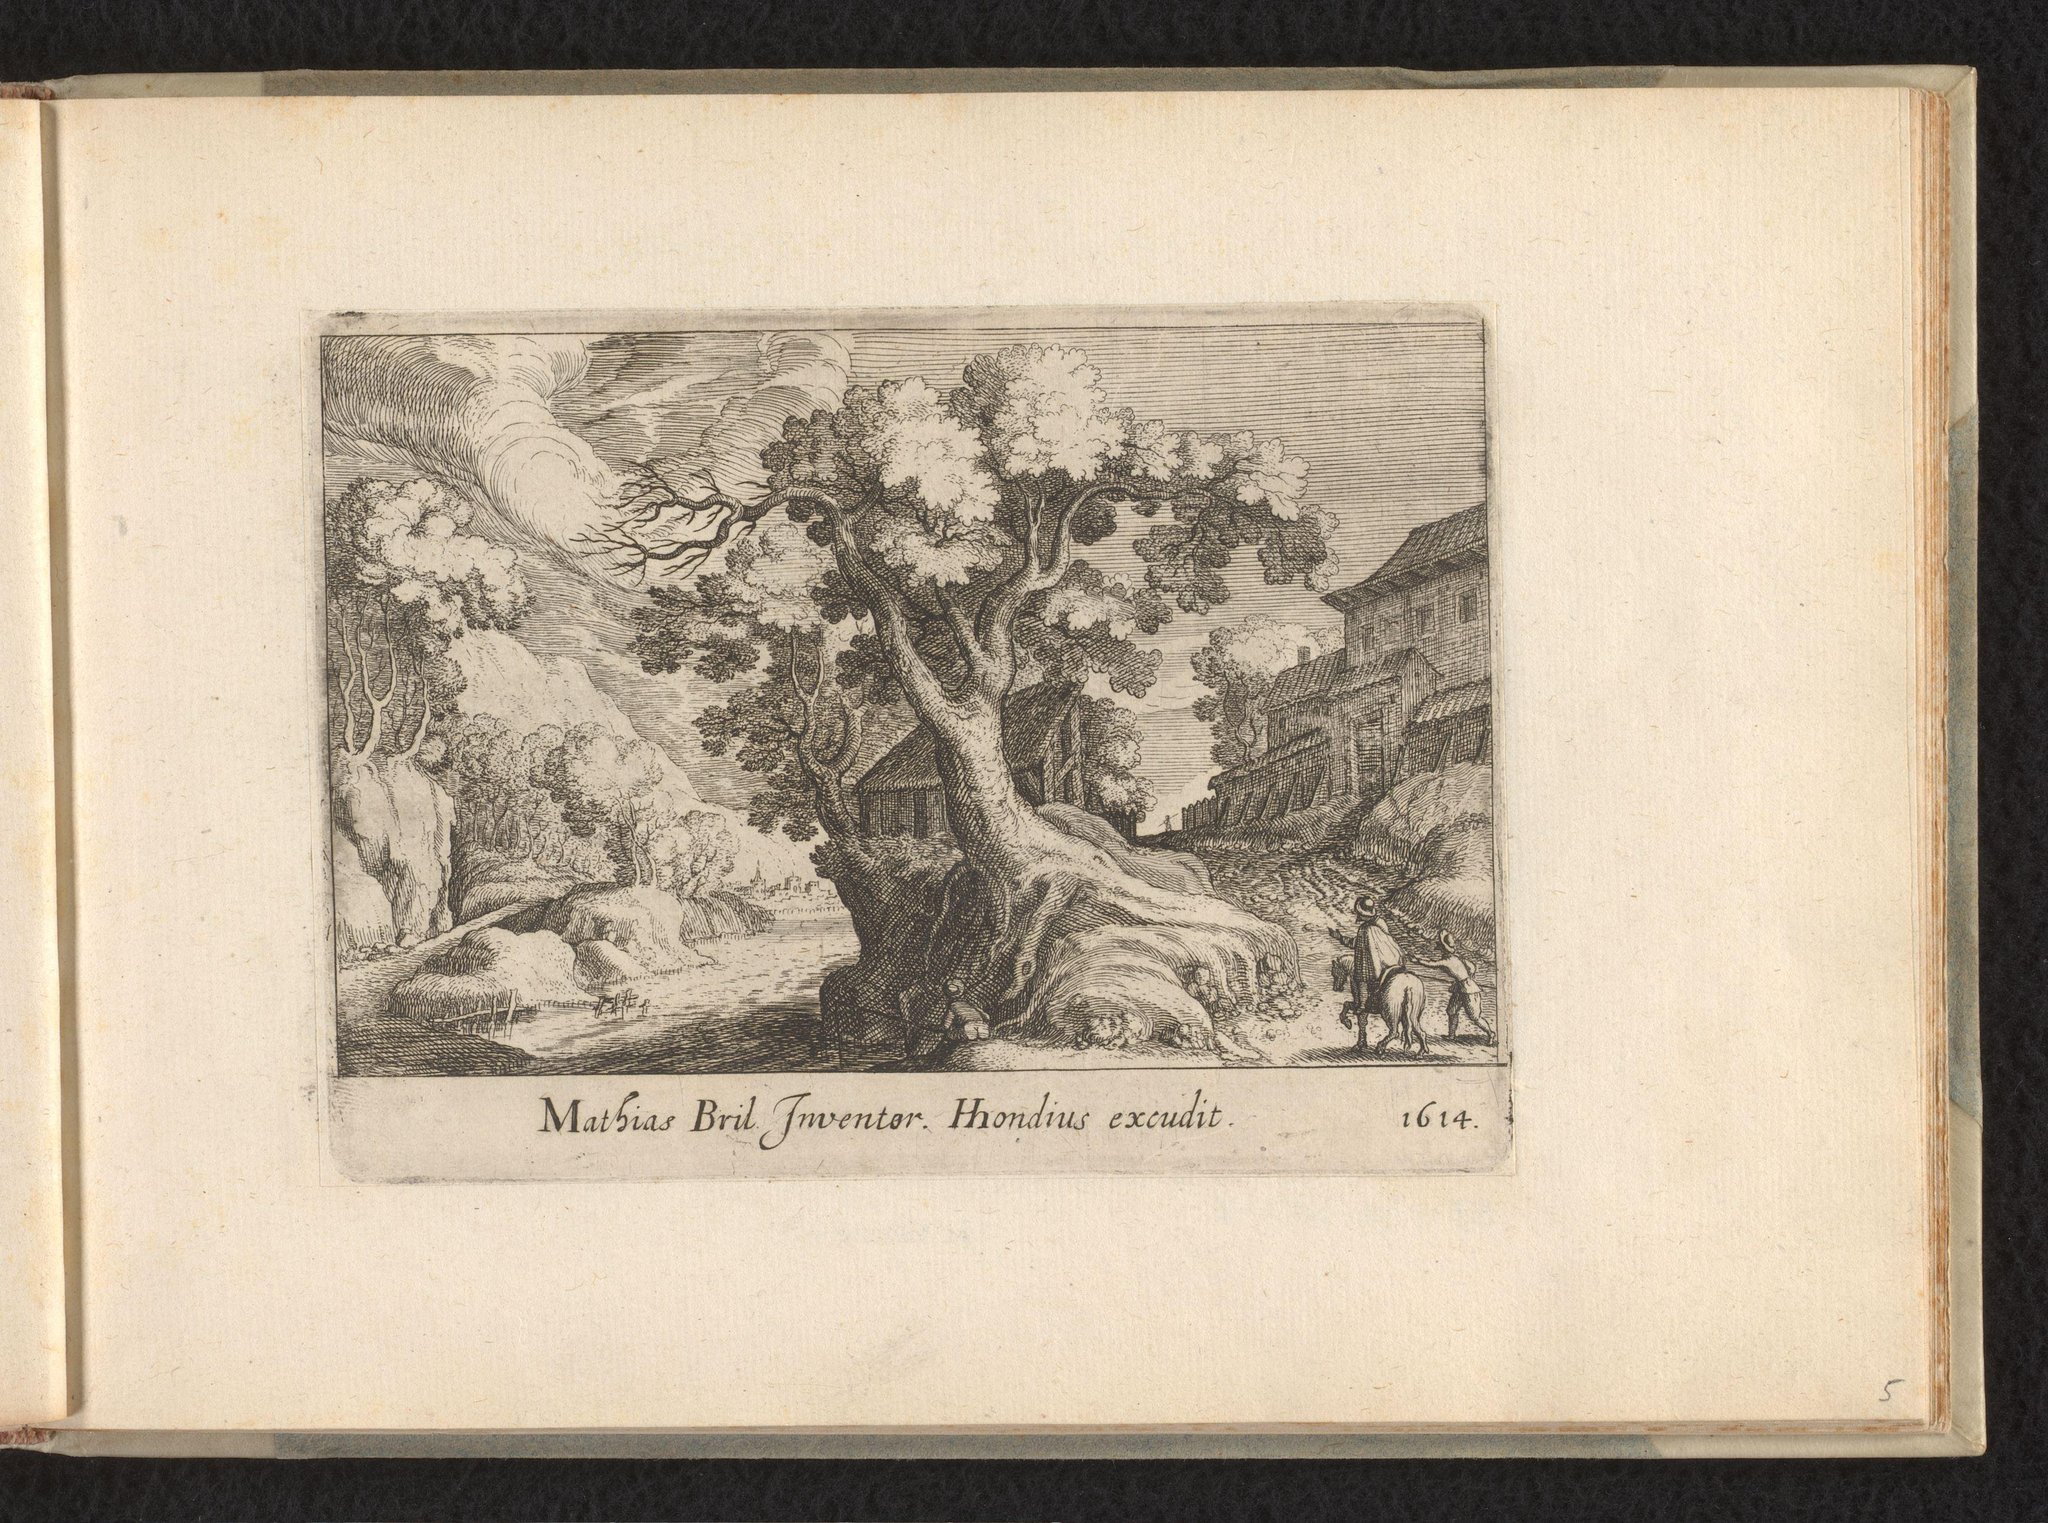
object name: print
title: Topographia Variarum Regionum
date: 1614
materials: paper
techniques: etching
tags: landscapes, angling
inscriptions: date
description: Op de landweg rechts een ruiter en een lopende man. Het pad voert naar enkele huizen. Links een rivier met hoge linkeroever.